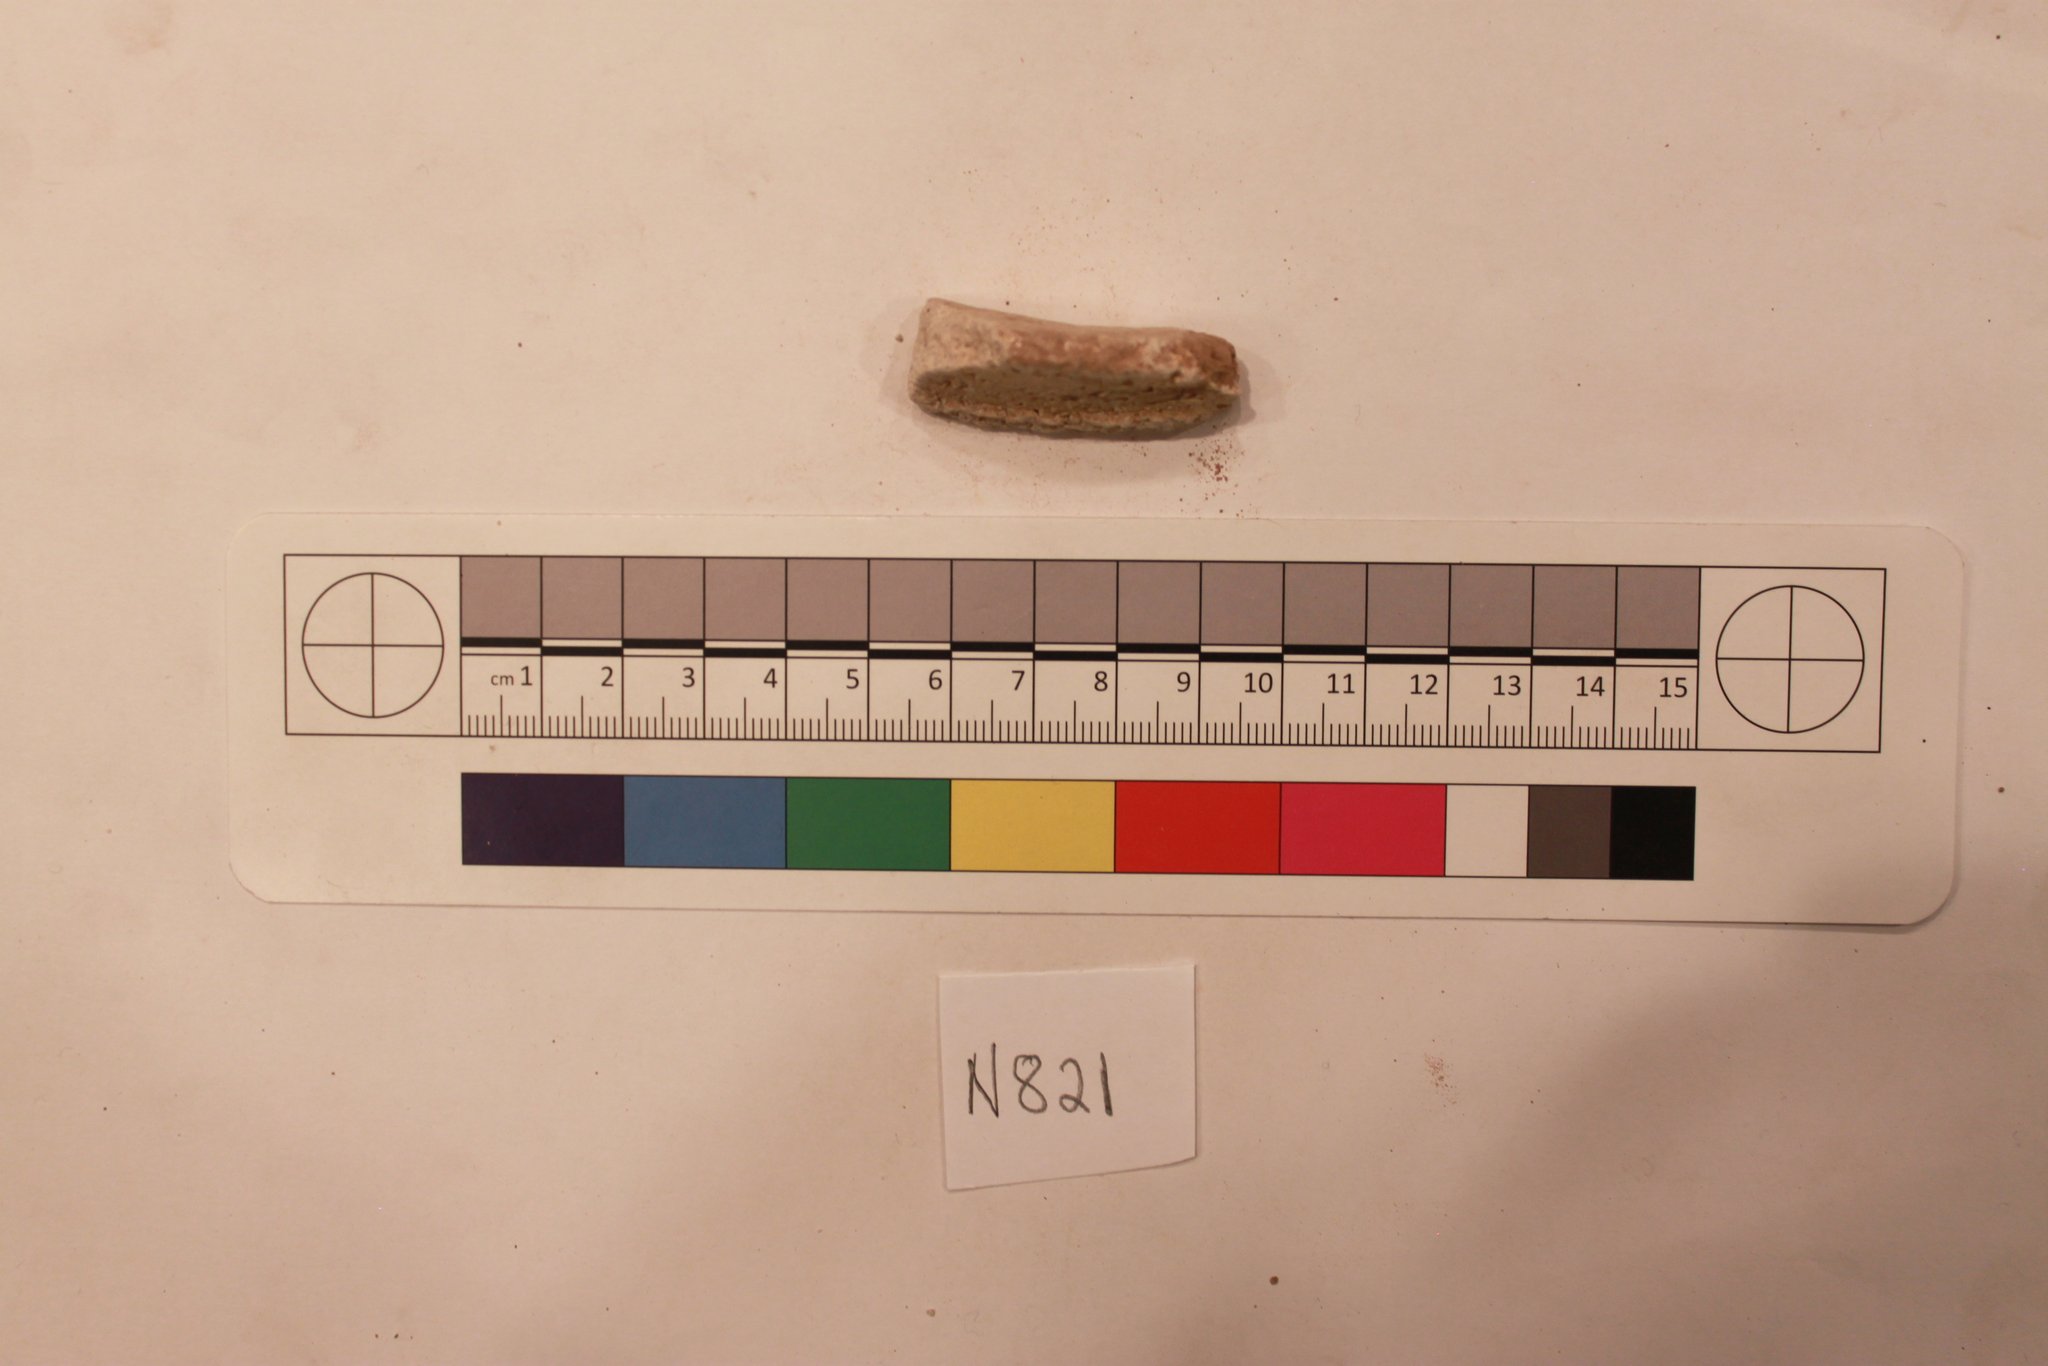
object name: fragment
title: Stucco Fragment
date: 701-1200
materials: plaster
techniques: carving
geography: iran